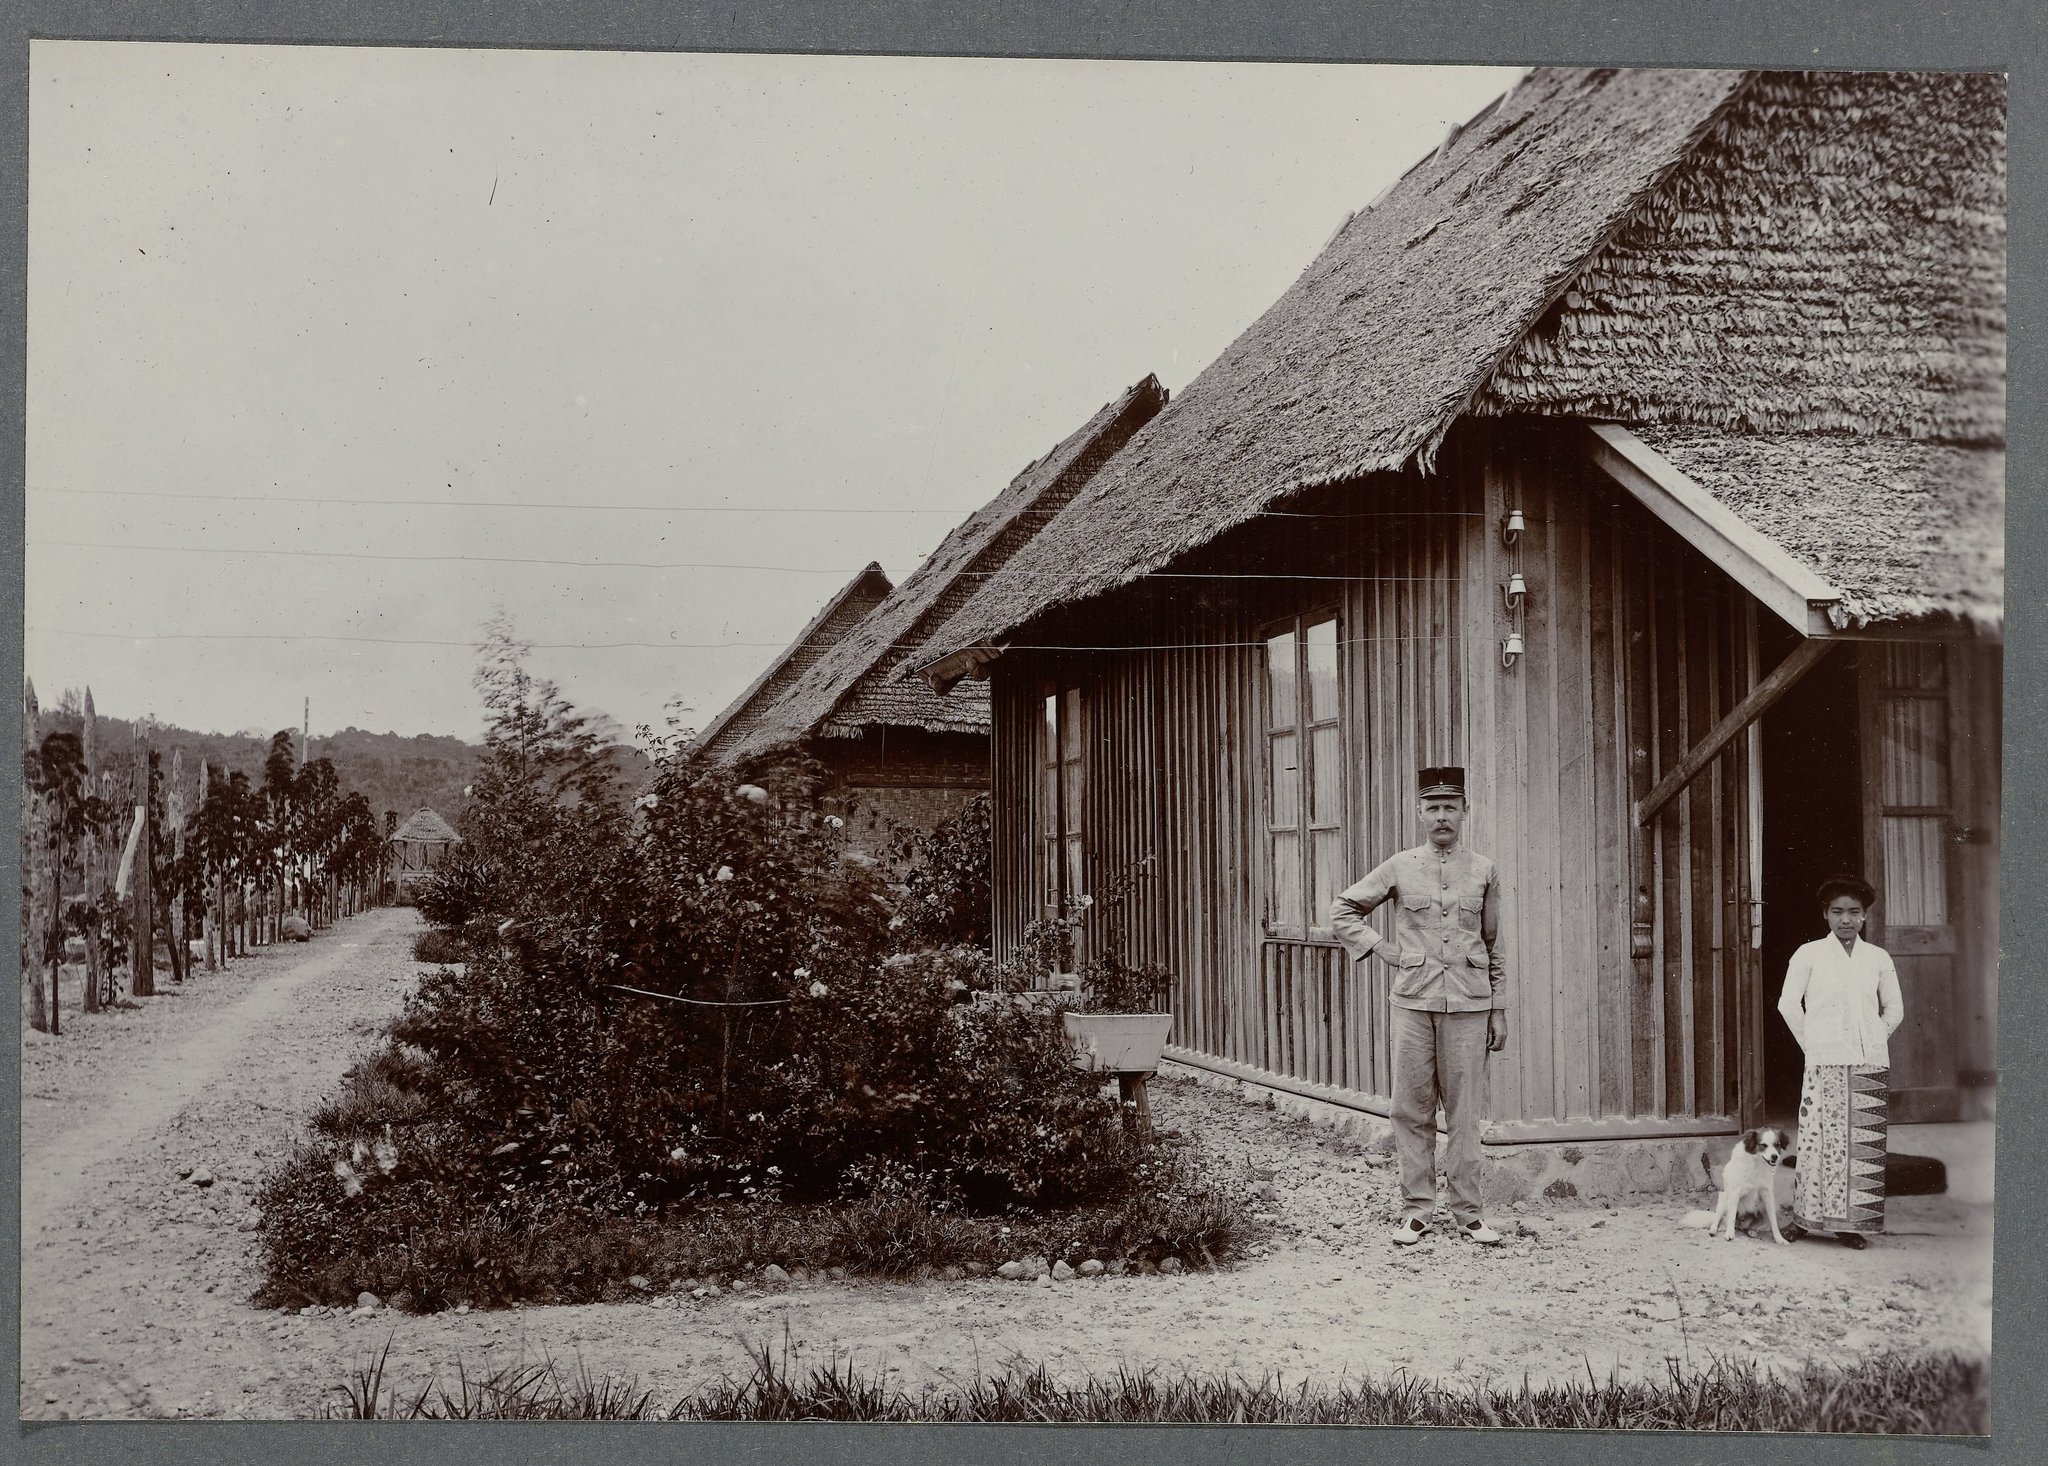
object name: photograph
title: Gebouwen in bivak Lampahan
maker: Anonymous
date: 1903-1913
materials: photographic support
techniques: gelatin silver print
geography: north sumatra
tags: arnhem, albertus dominicus laman trip, building activities, traffic by road or path with motor-vehicle, landscapes in tropical and sub-tropical regions, road, path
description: Na de expedities naar de Gajo- en Alaslanden o.l.v. Van Daalen (eerste tocht in 1901), werd hij in 1903 belast met voorbereiding van permanente vestiging van Nederlands gezag. Aanleg van een weg van de Noordkust naar het binnenland was hierbij van groot belang. Deze zgn. Gajoweg werd aangelegd tussen 1903 en 1914, van Bireuen aan de kust naar Takinguen aan het bergmeer Danau Lauttawar, totale lengte 104 km.